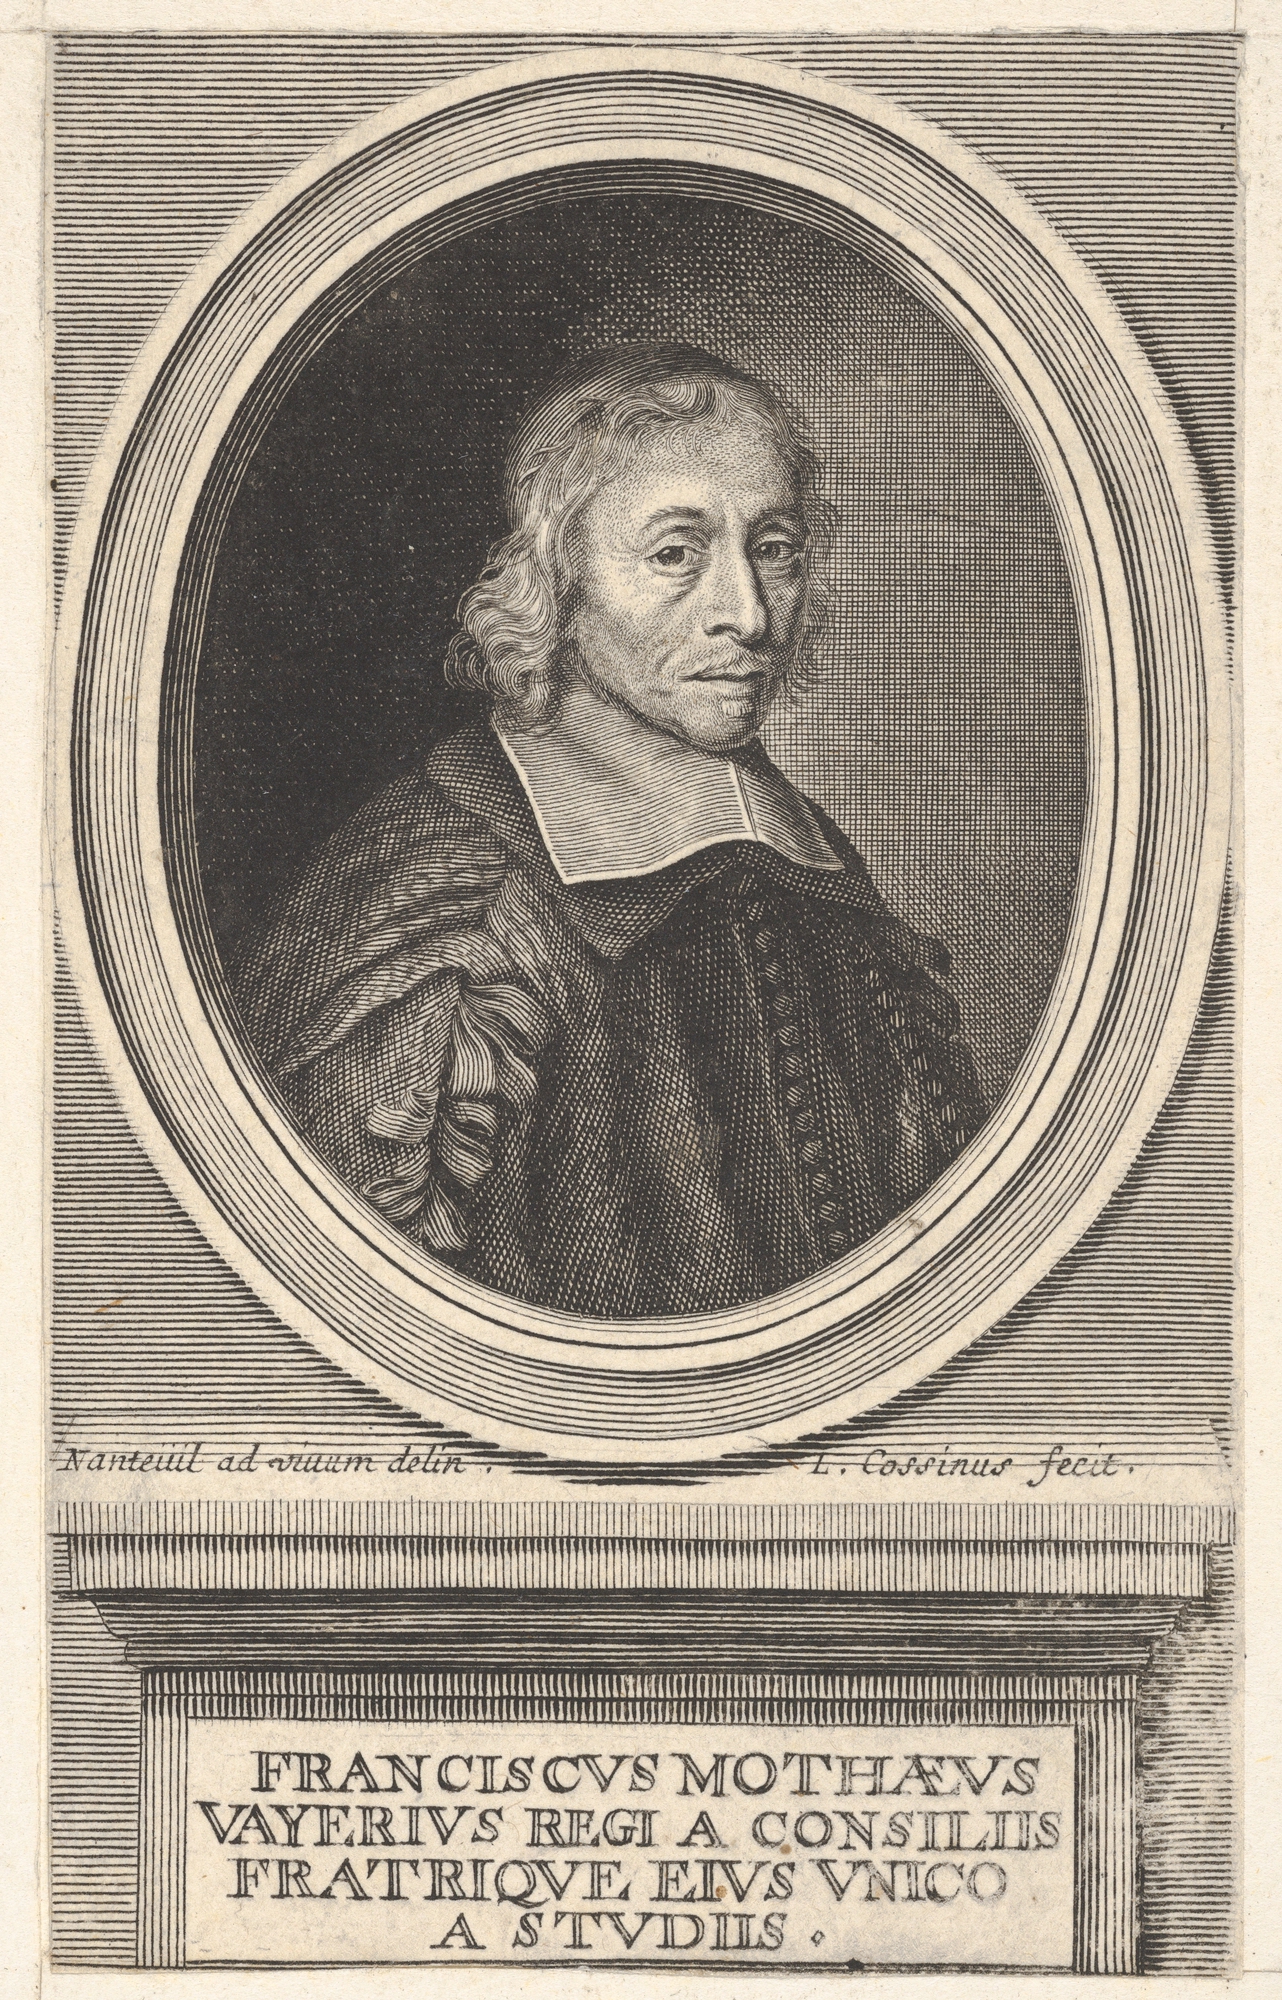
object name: print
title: François de La Mothe le Vayer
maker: louis cossin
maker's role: artist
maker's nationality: french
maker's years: 1627-1704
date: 1601-1700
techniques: engraving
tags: men,portraits